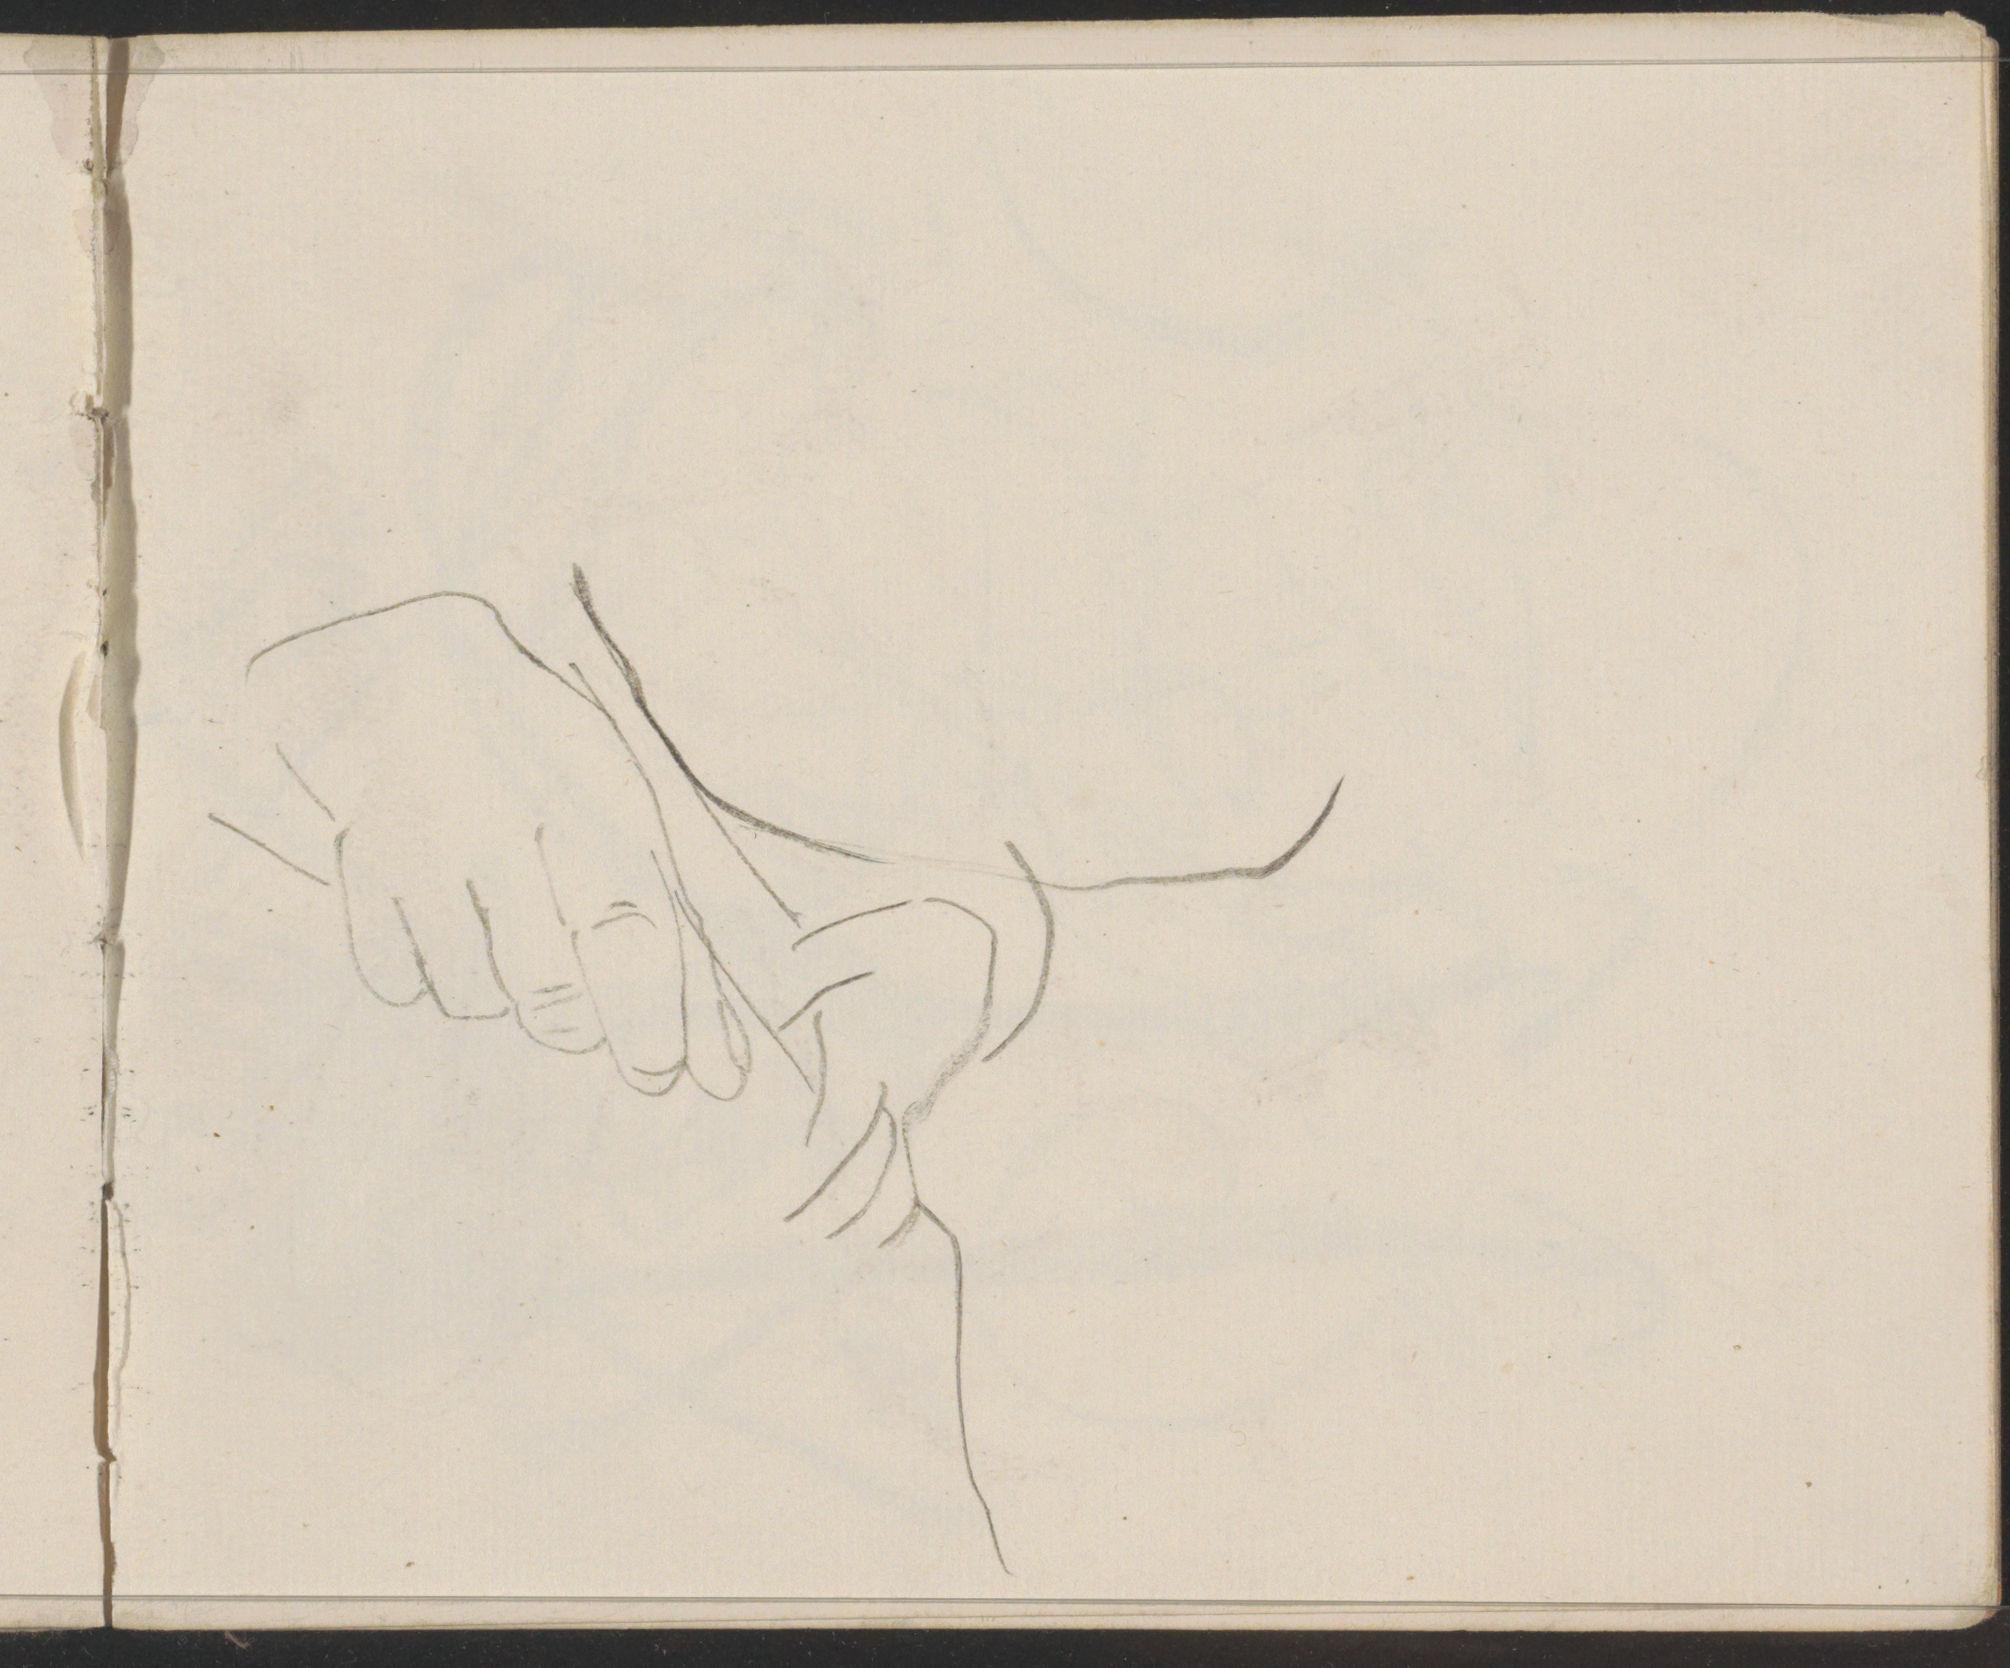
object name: sketchbook leaf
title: Handen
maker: carel adolph lion cachet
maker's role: draughtsman, print maker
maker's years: 1864-1945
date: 1895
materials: chalk, paper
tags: hand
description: Blad 7 recto uit een schetsboek met 11 bladen.